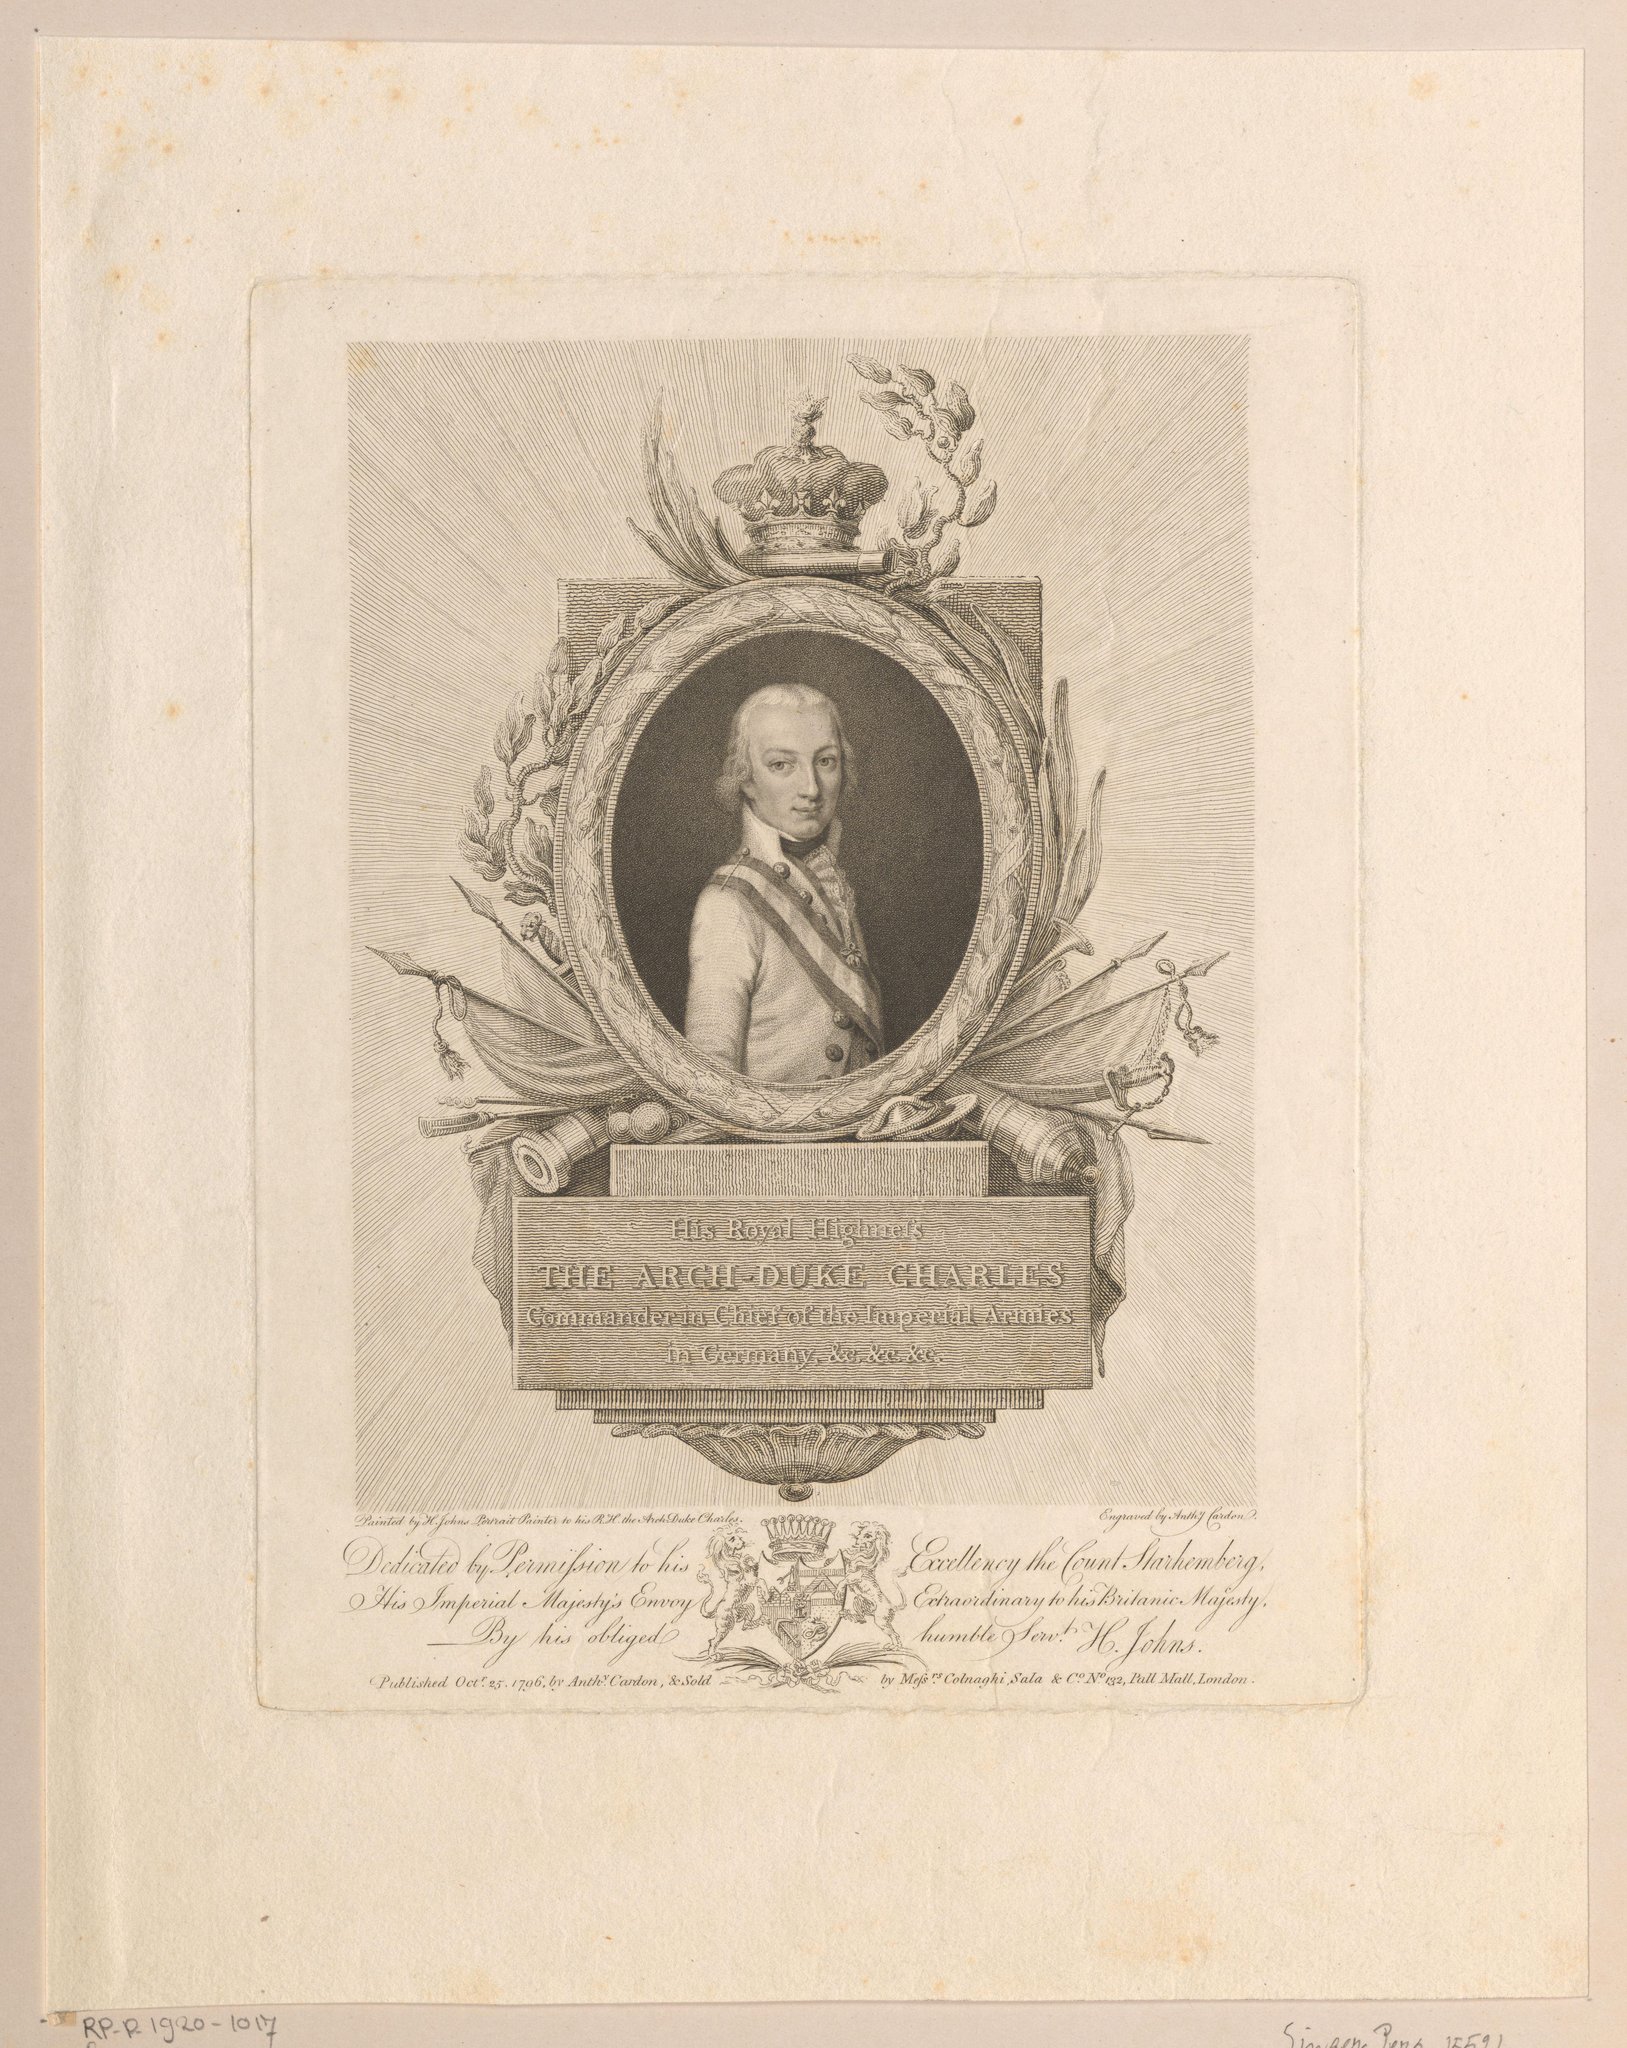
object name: print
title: Portret van Karel van Oostenrijk-Teschen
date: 1796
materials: paper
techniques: engraving, etching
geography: london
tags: vienna, historical persons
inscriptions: collector's mark: Lugt 2228